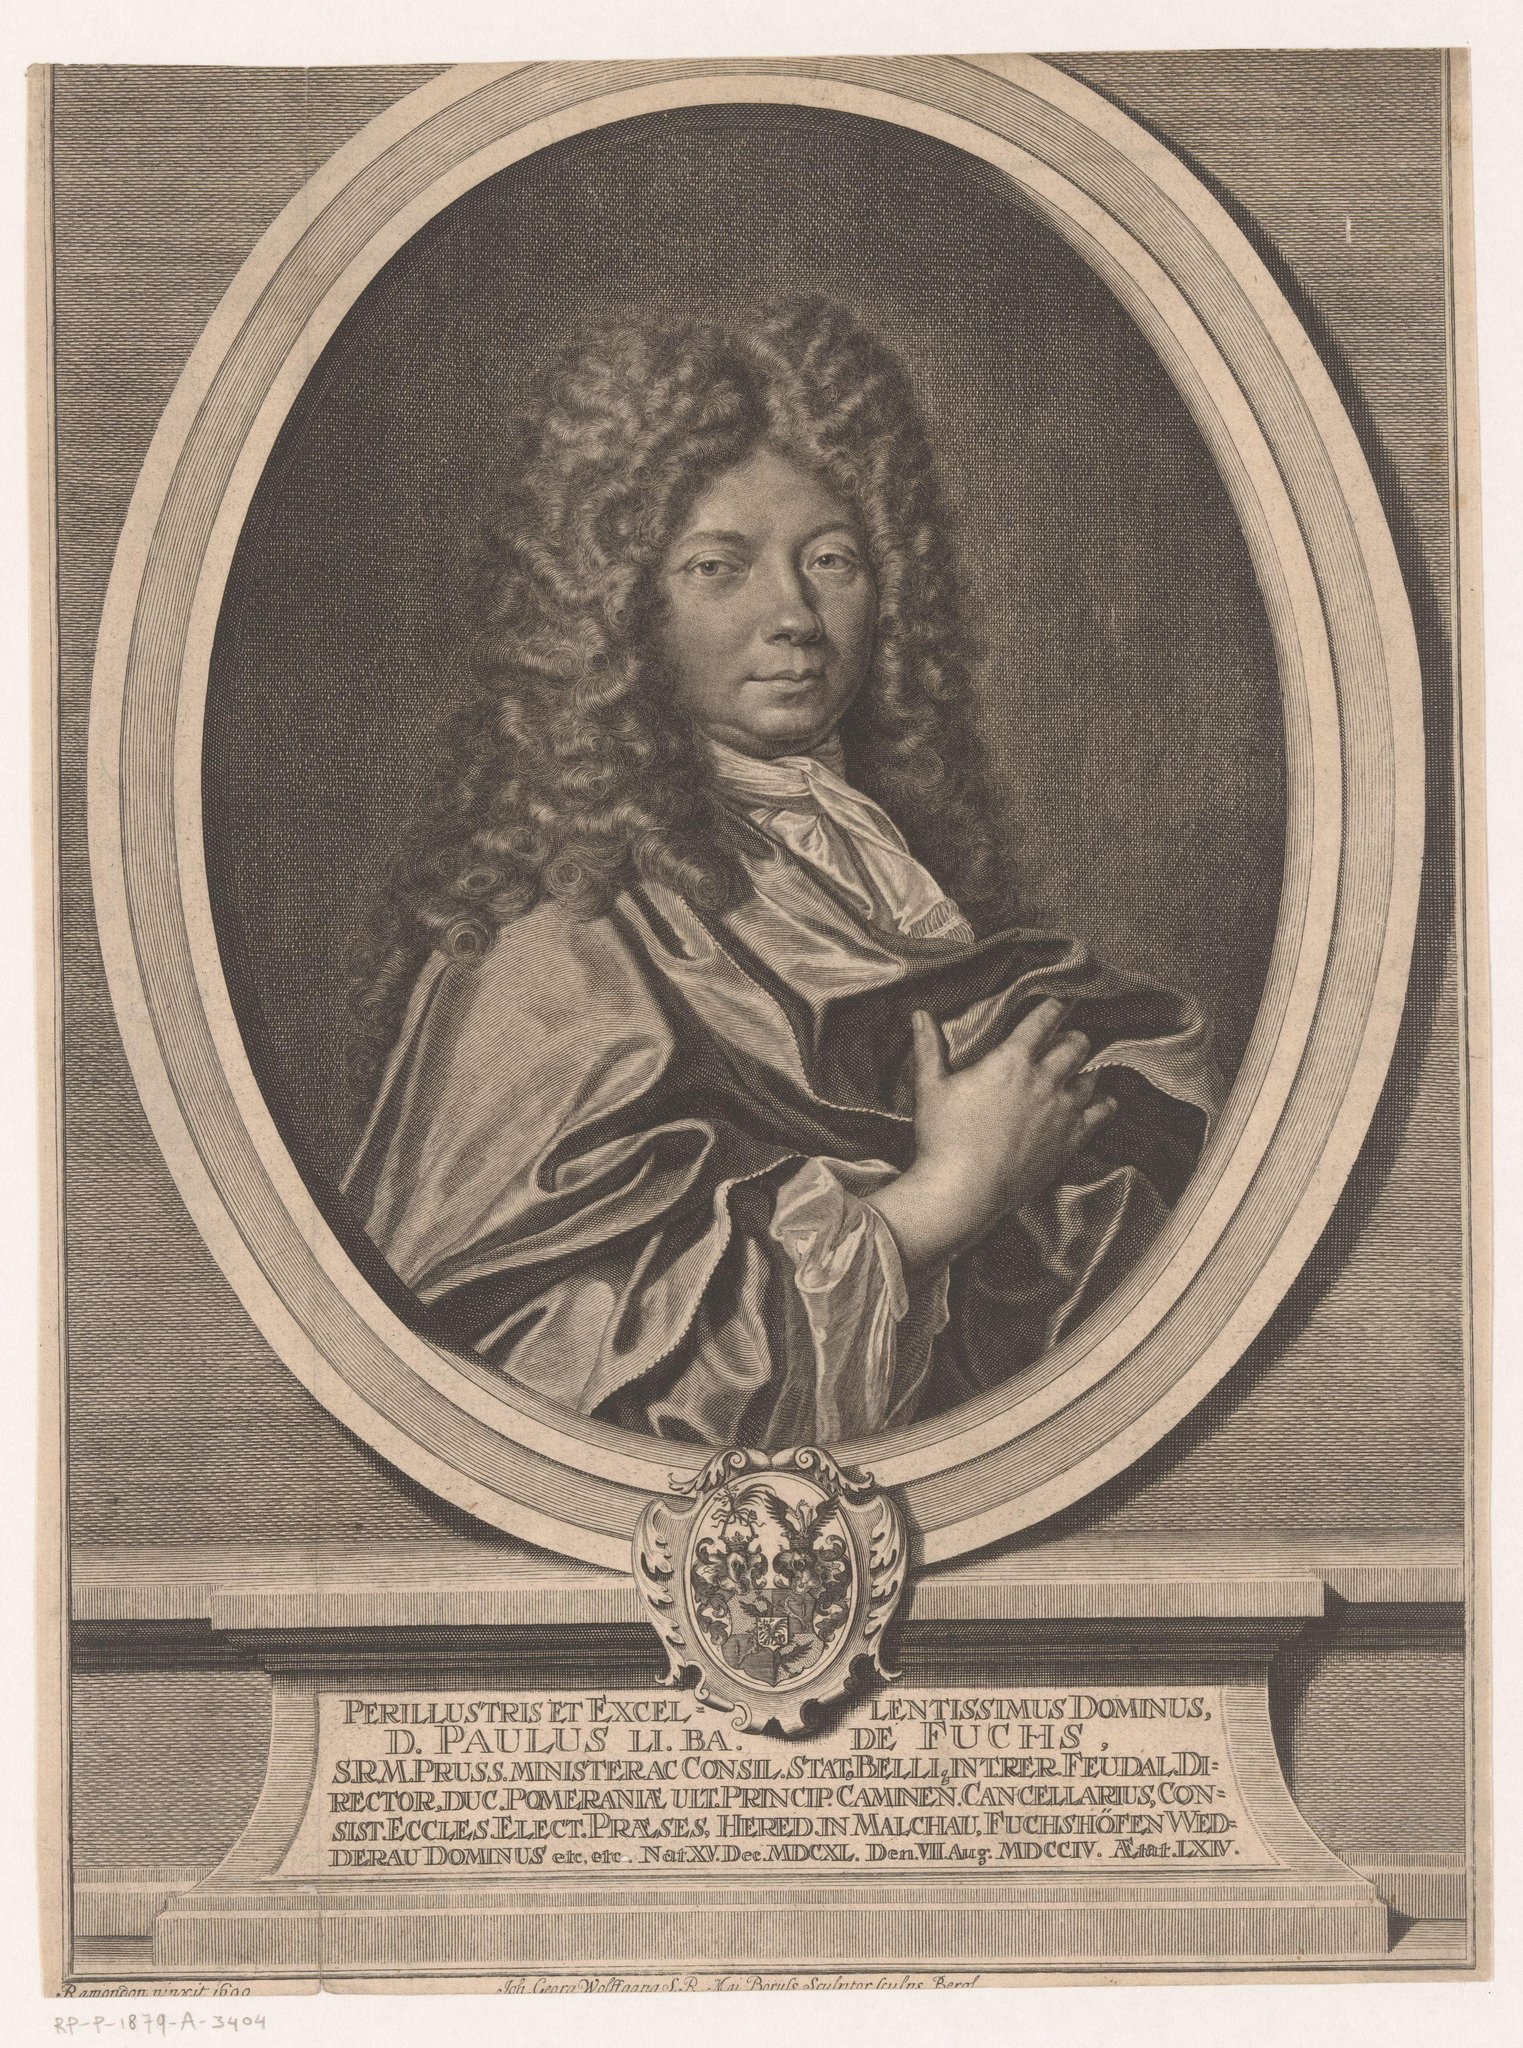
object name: print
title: Portret van Paul von Fuchs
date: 1672-1744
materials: paper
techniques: engraving, etching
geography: berlin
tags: historical persons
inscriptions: verso